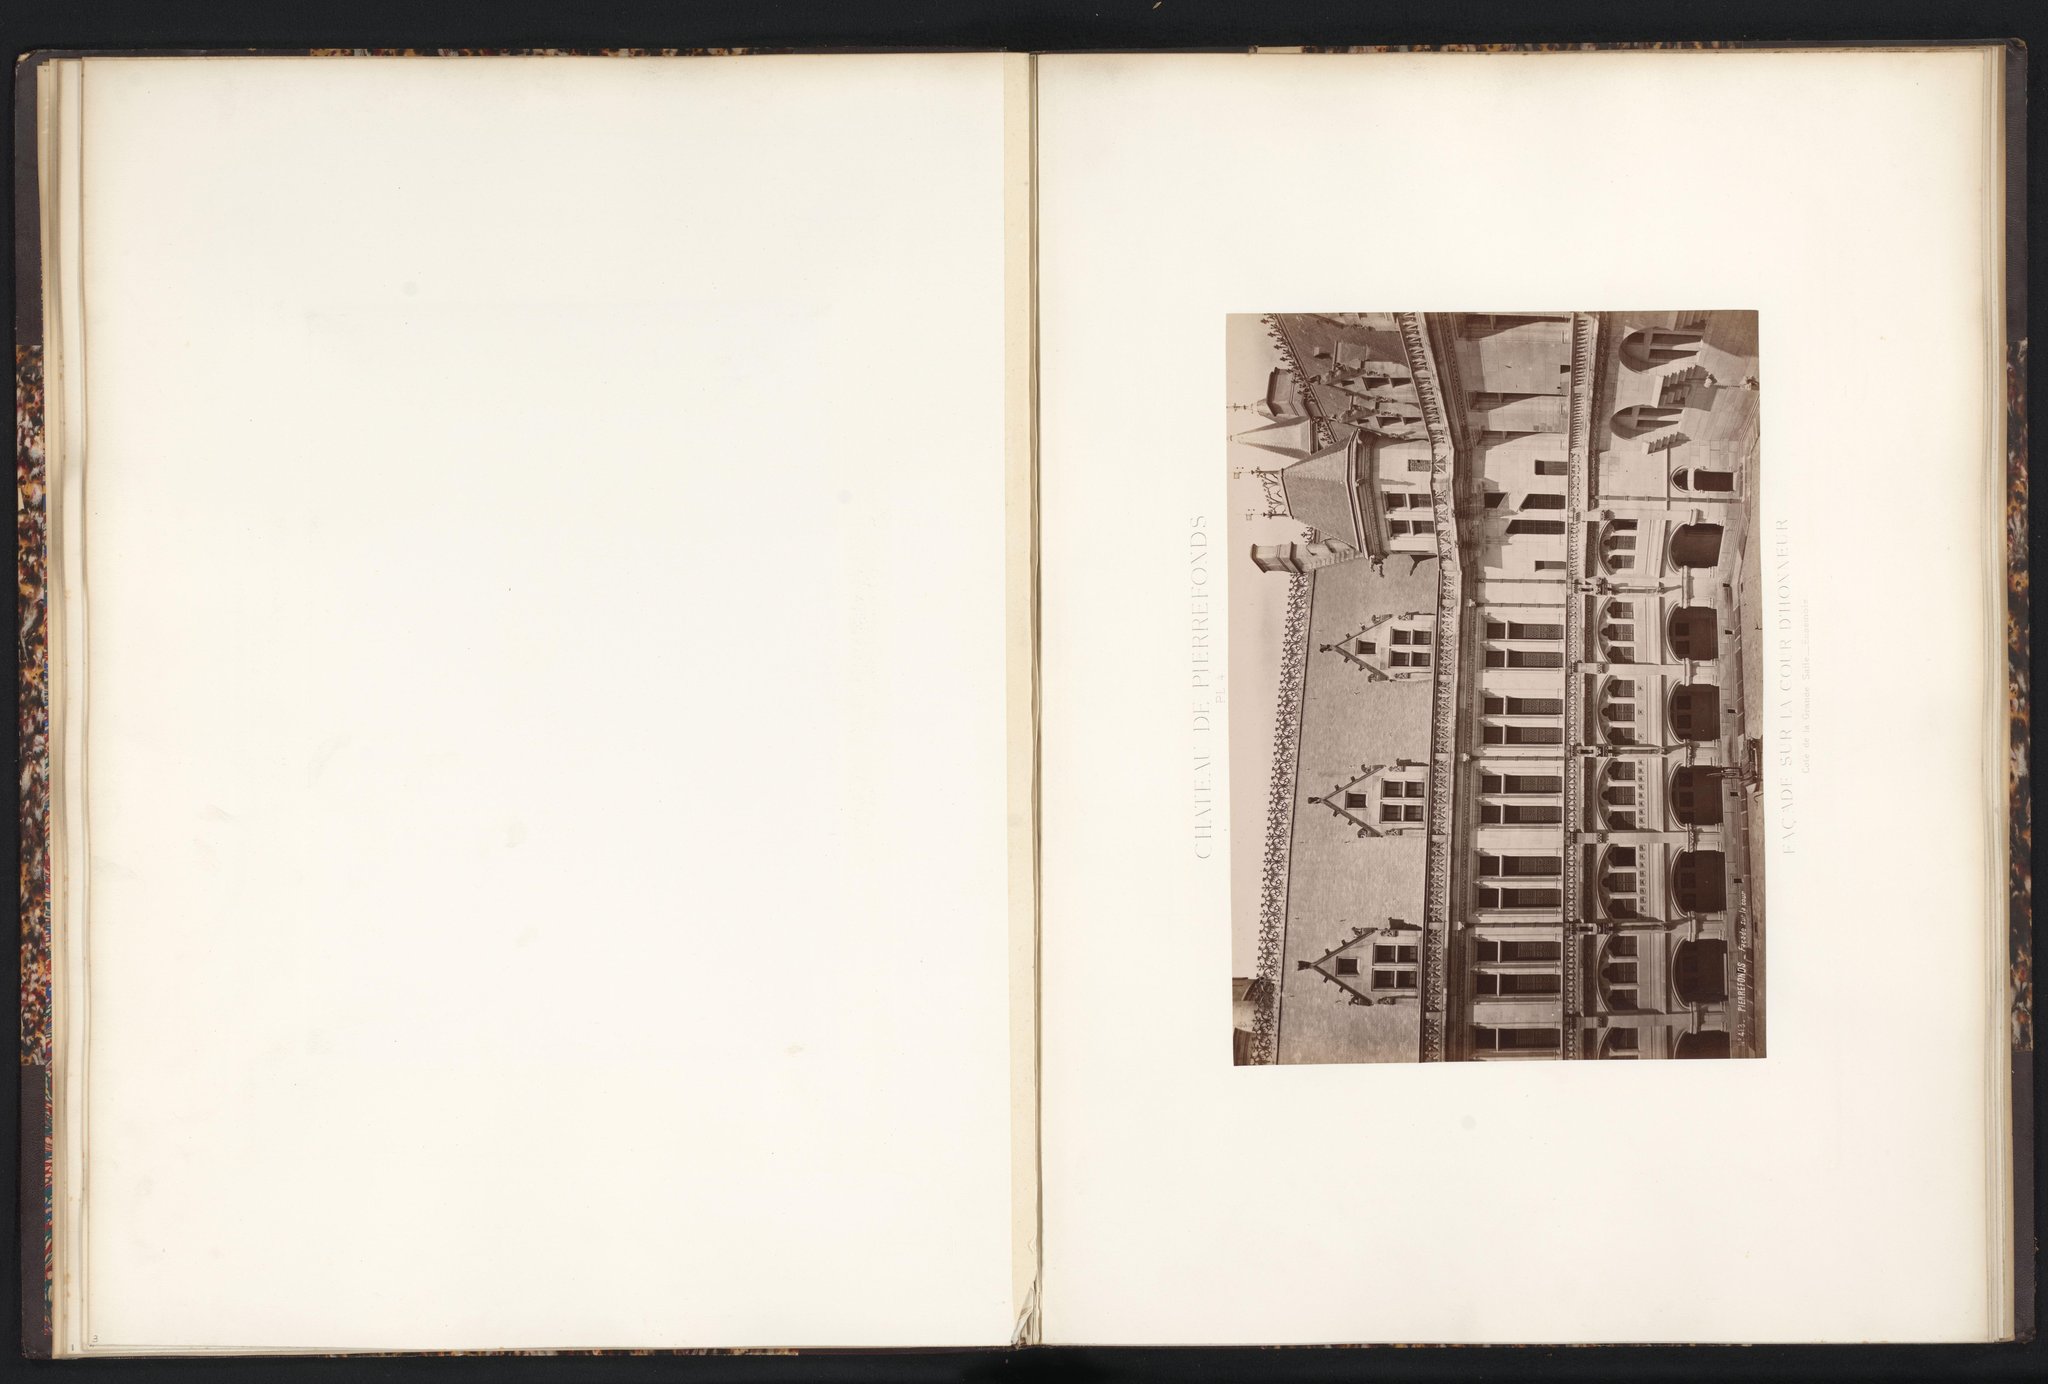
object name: page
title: Gezicht op de binnenplaats van het kasteel van Pierrefonds, Frankrijk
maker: séraphin-médéric mieusement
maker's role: fotograaf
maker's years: 1840-1905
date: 1870-1875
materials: photographic support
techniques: albumen print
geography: pierrefonds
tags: castle, courtyard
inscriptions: number: ‘PL. 4.’, inscription: ‘No 143. PIERREFONDS - Façade sur la Cour’